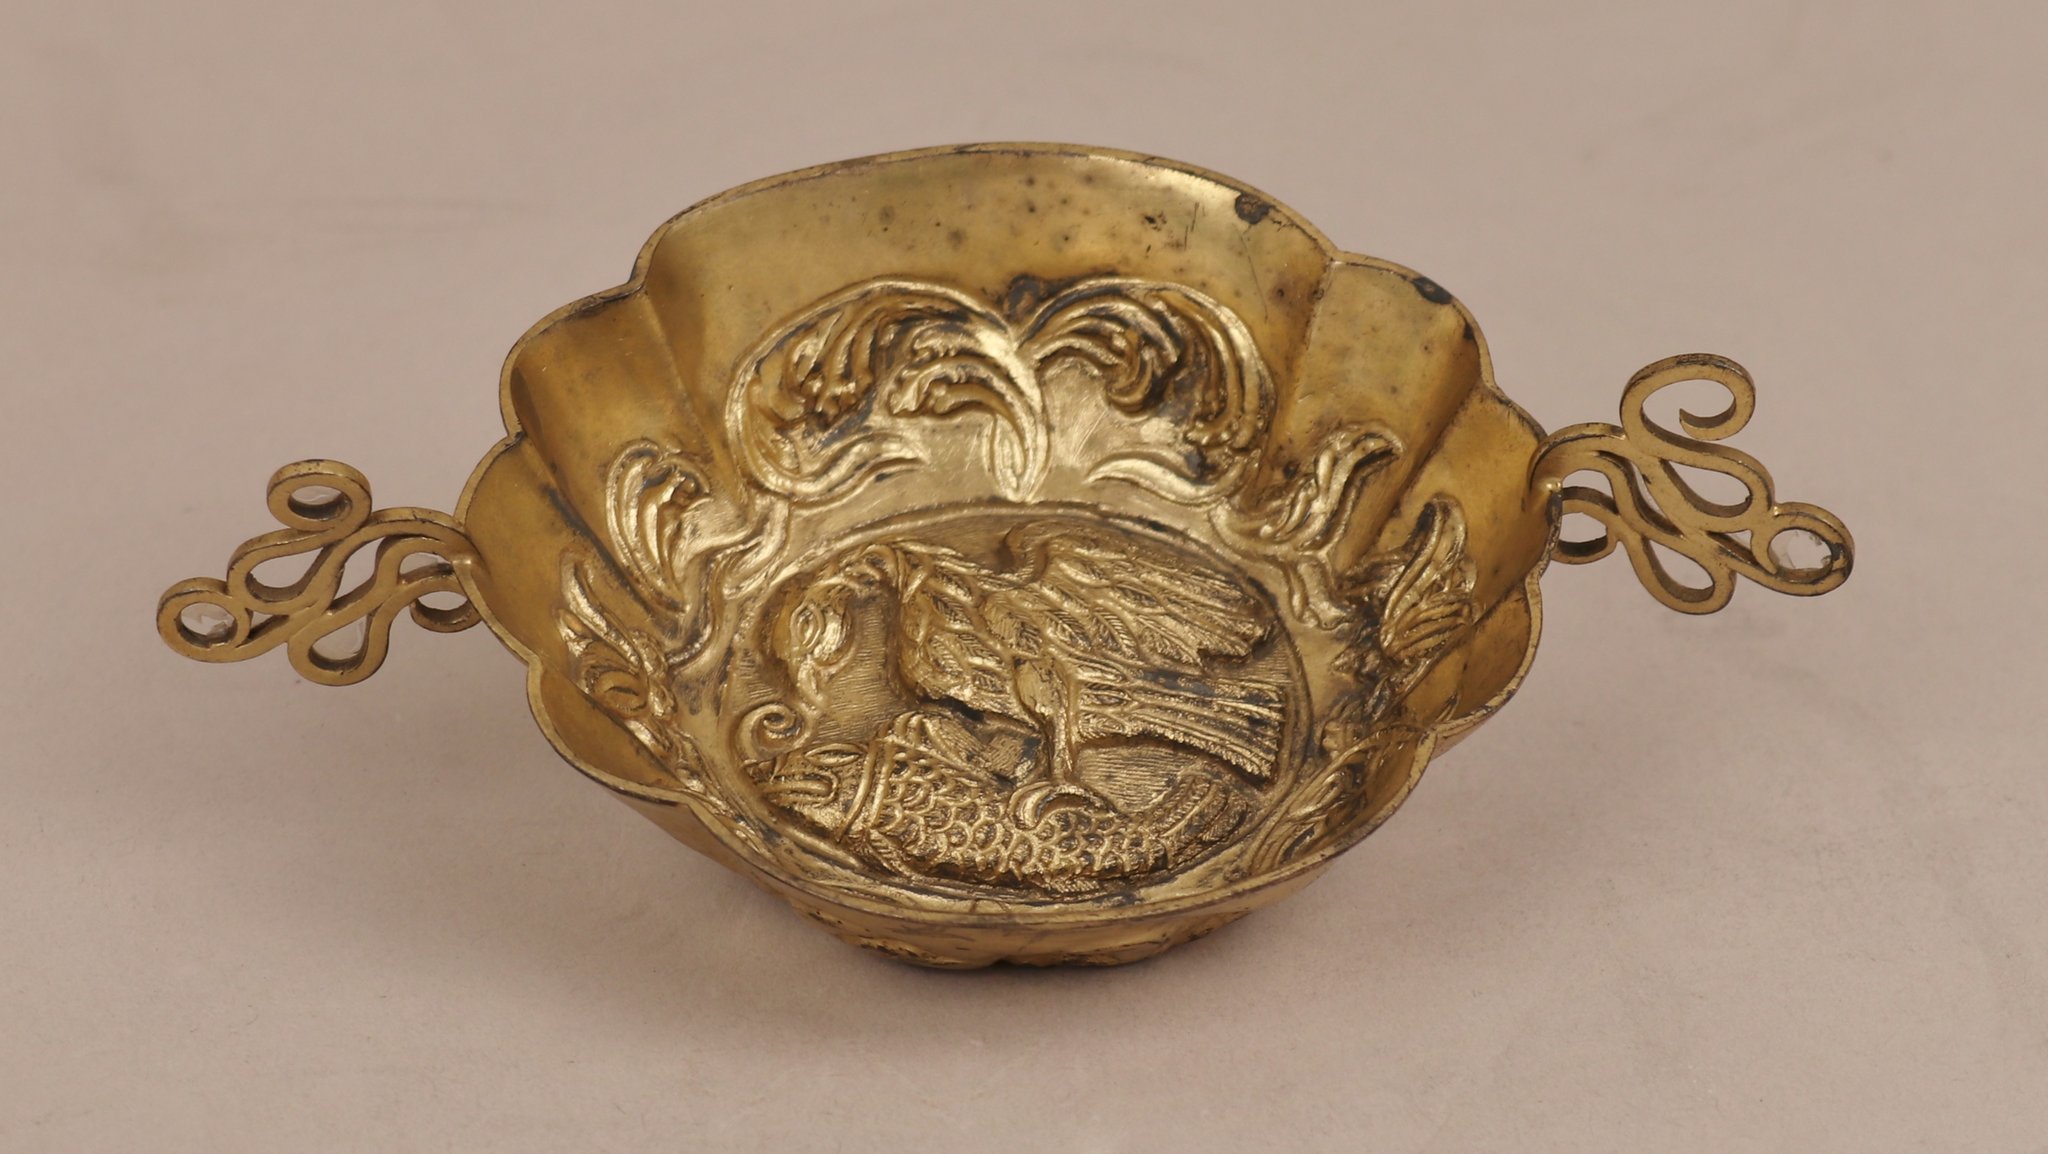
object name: cup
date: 1801-1900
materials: metal, silver